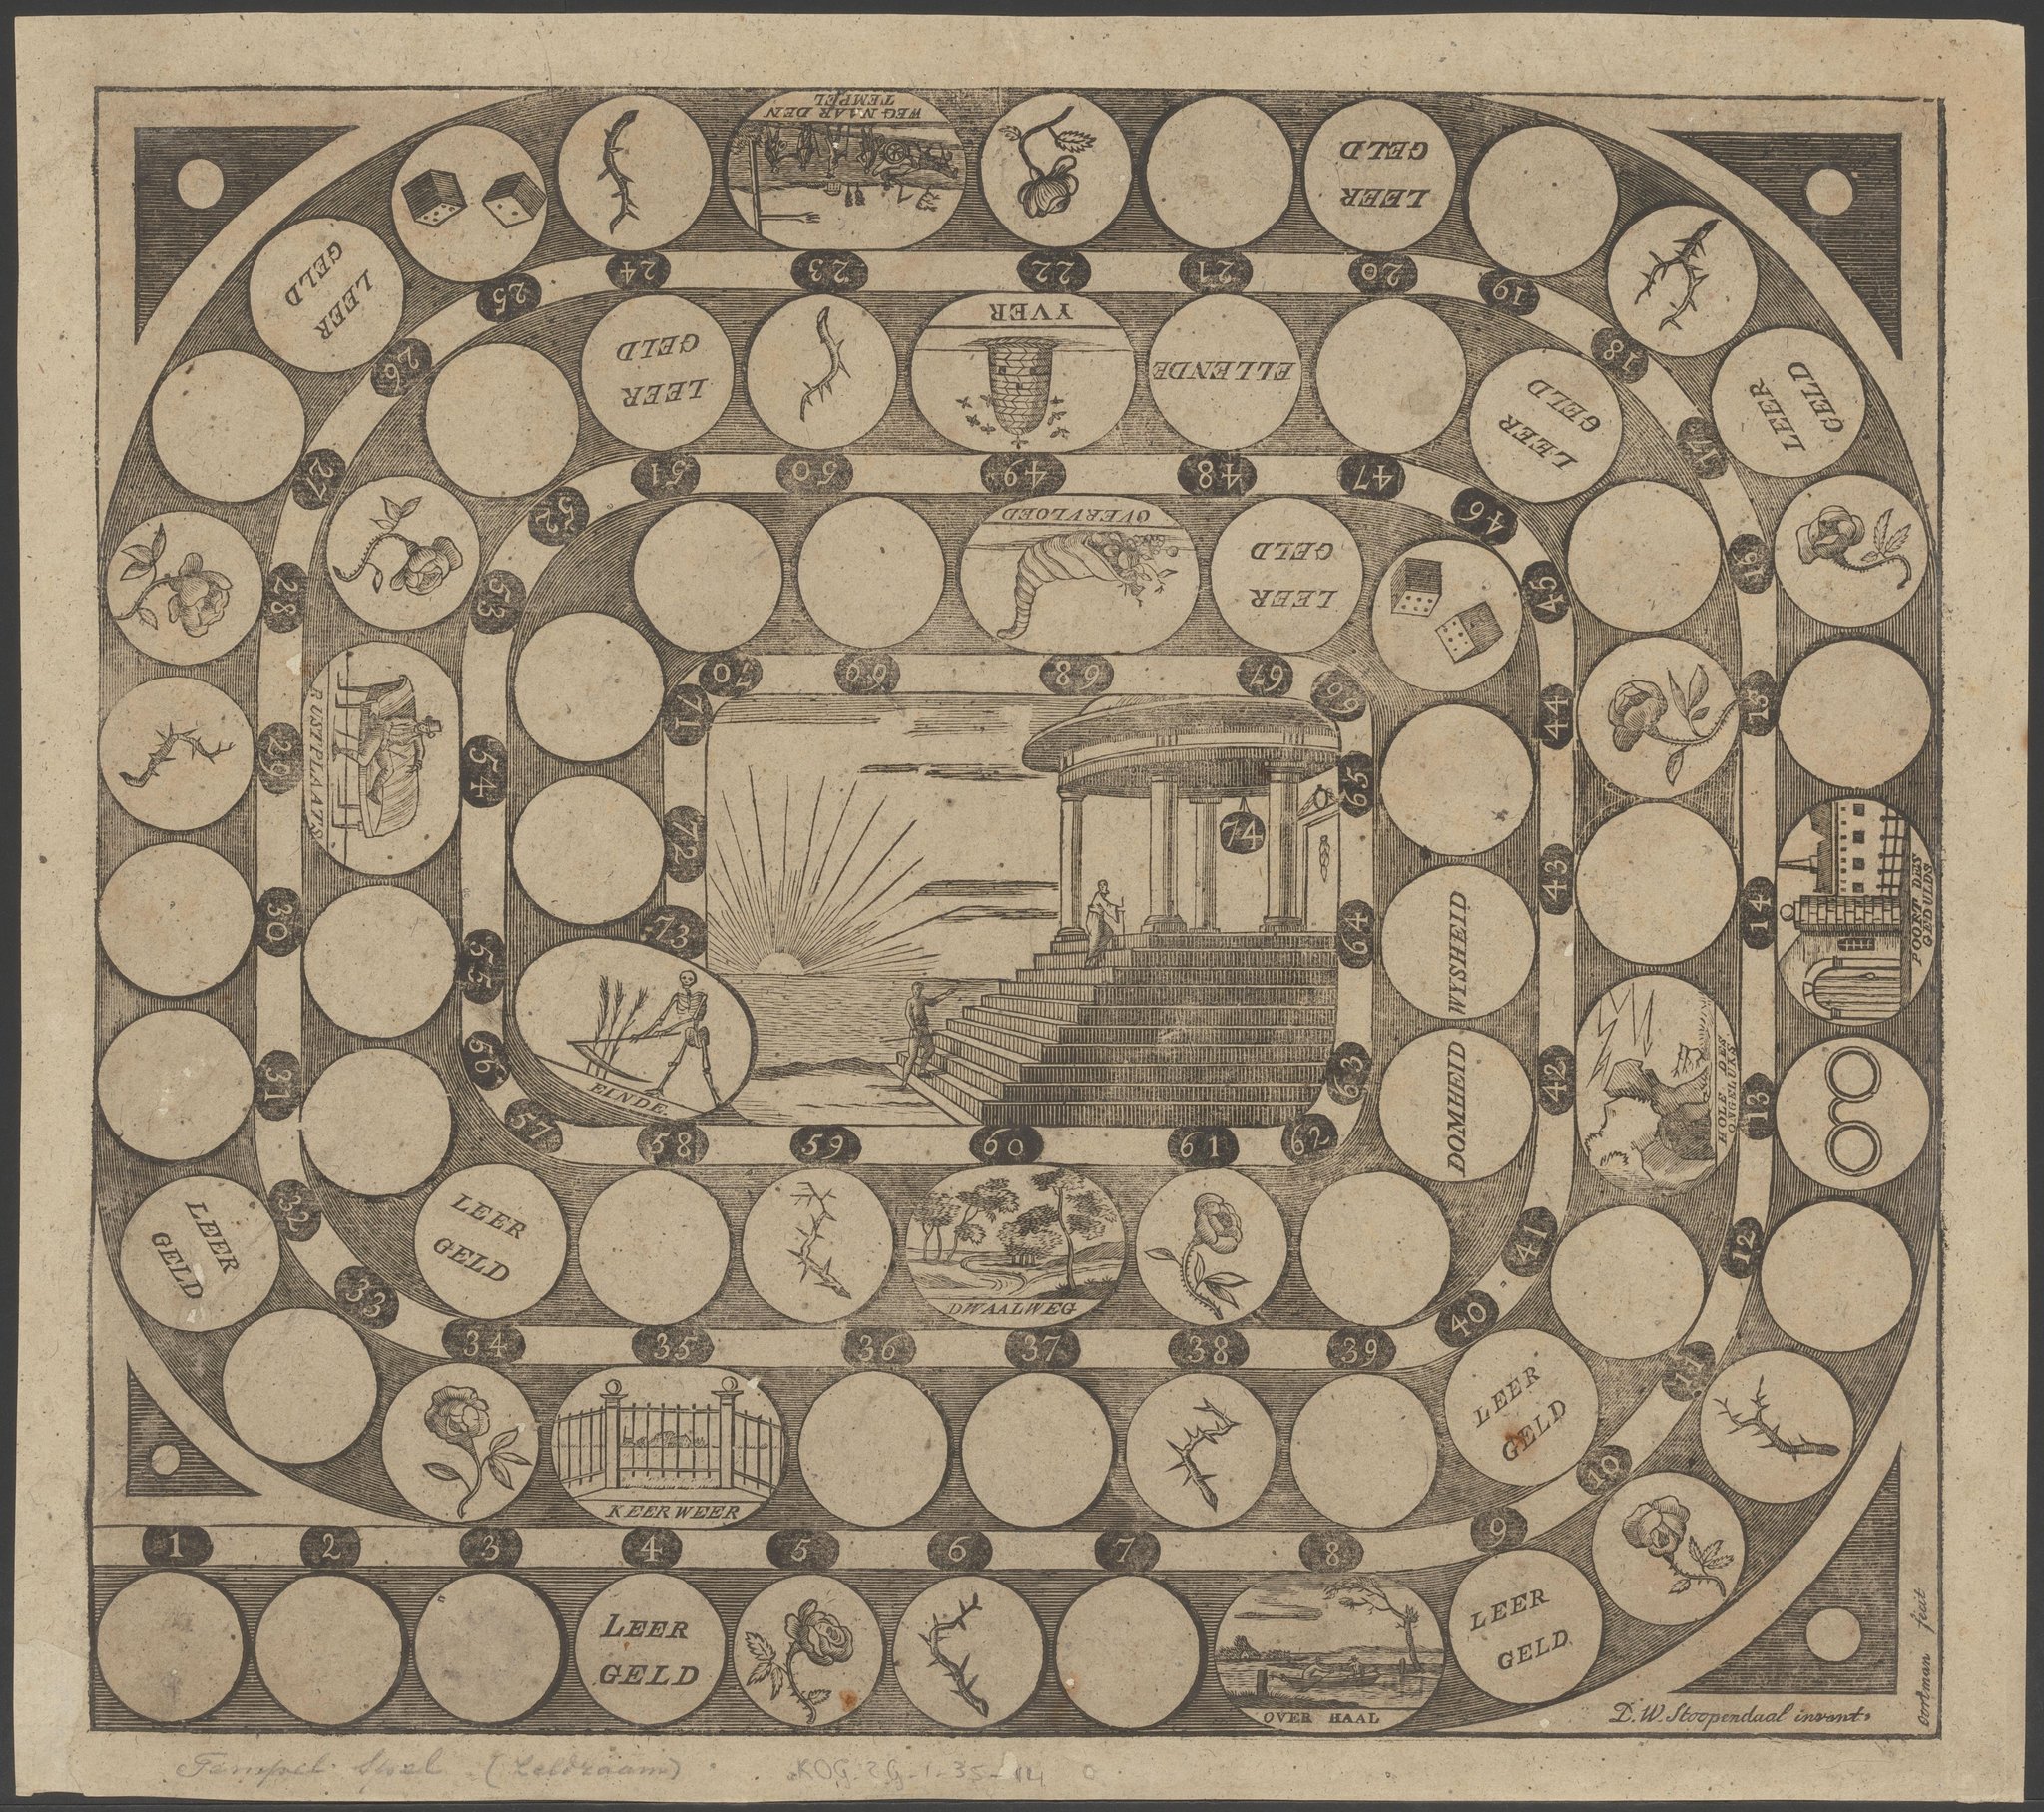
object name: gameboard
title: Speelbord tempel van het geluk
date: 1816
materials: paper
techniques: letterpress printing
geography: amsterdam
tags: animals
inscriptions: stamp, collector's mark: Lugt 1641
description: Spiraalvormig bordspel met vakken genummerd van 1 tot en met 74. Op het middenveld een voorstelling van een tempel aan zee, die in de spelregels De Tempel van 't Geluk wordt genoemd. Onderwerpsrubrieken binnen de Atlas Zeden en Gewoonten: Zeden en gewoonten in engeren zin, Spel en vermaak, Gezelschapsspel II, Ganzenbord en dergelijke.